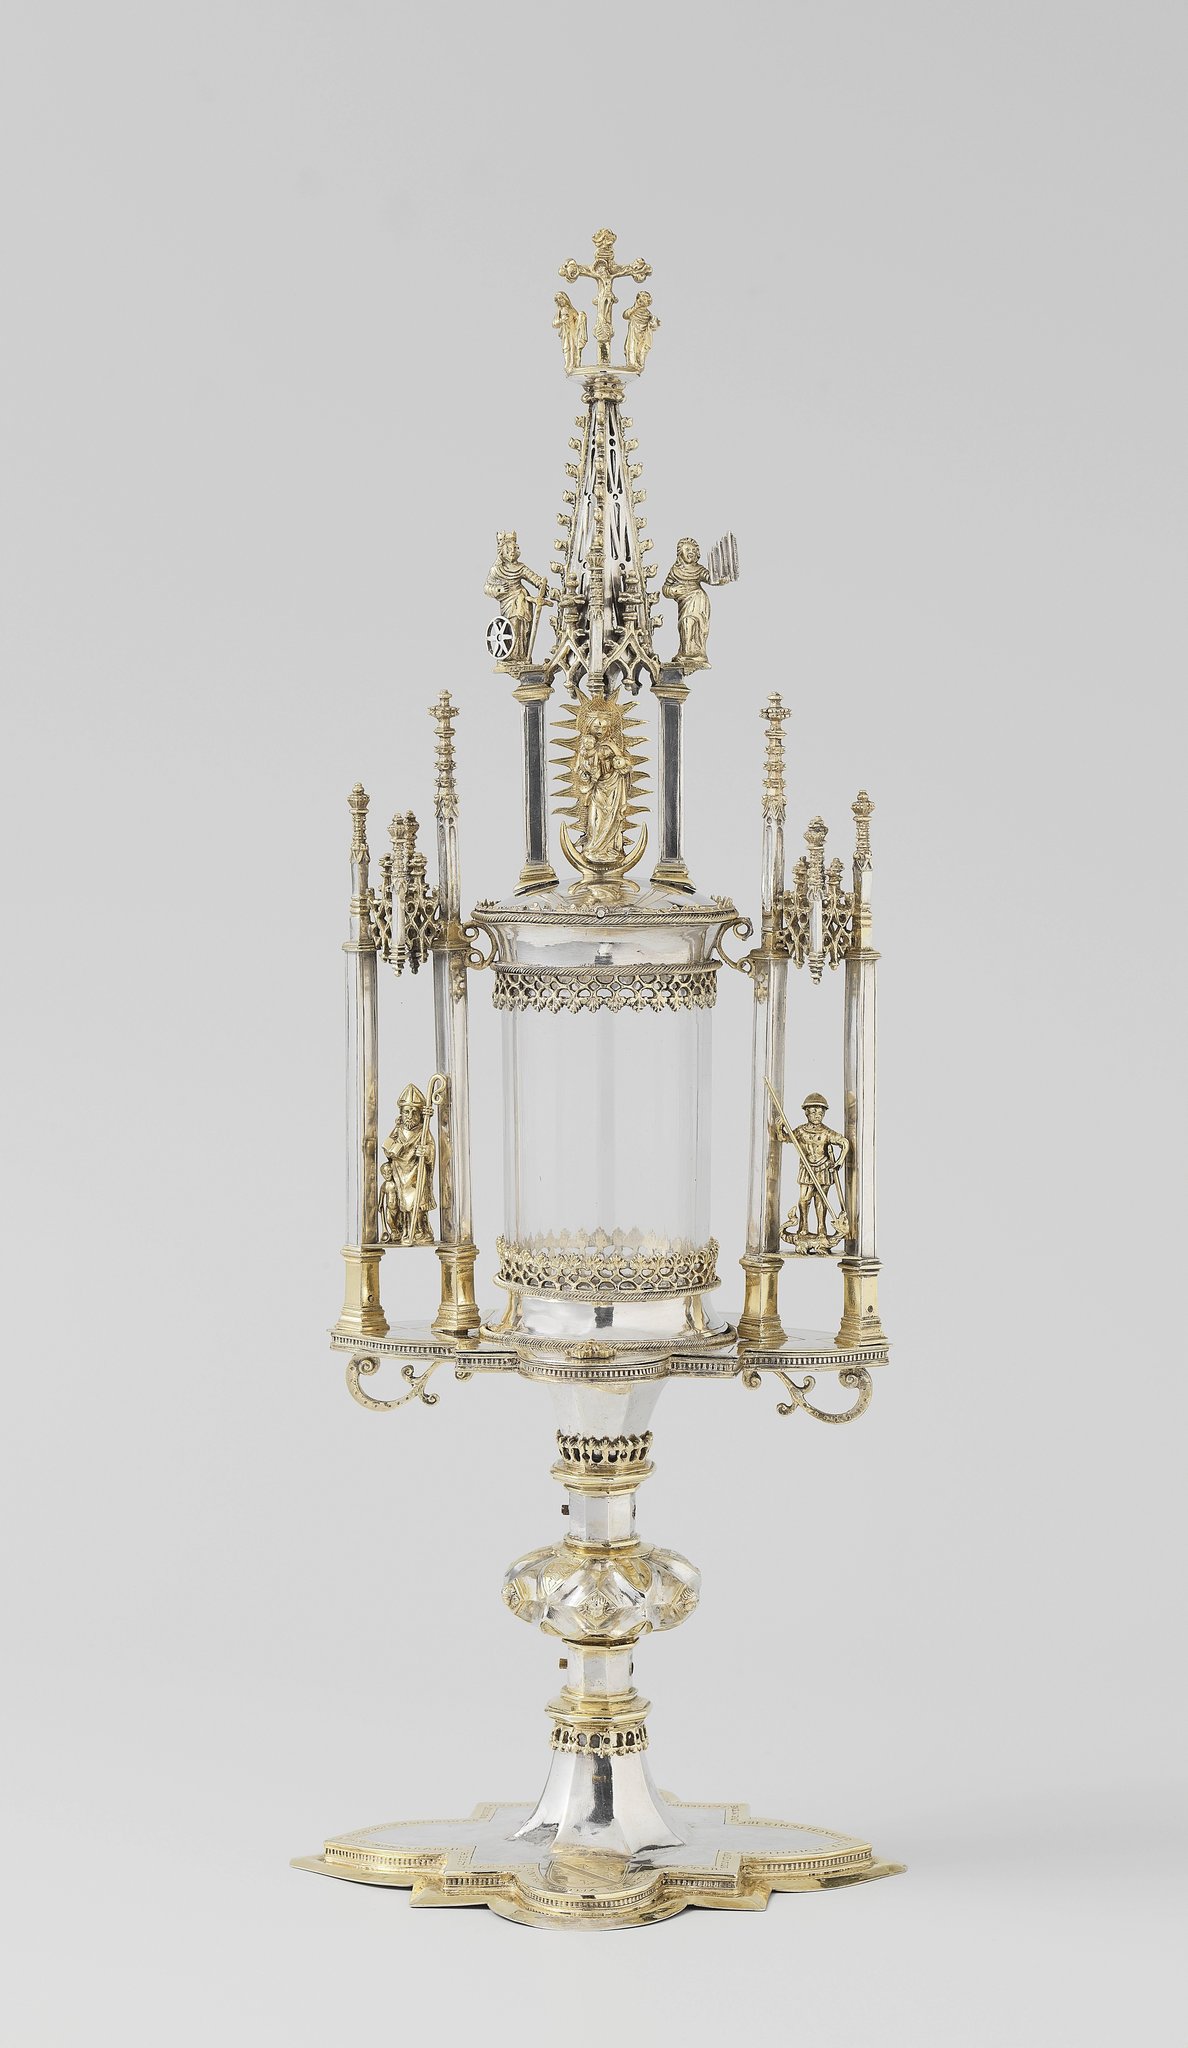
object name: monstrans, ostensorium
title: Monstrans uit een klooster te Sinnich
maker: Anonymous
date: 1525-1550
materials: glass, silver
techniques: gilding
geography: maastricht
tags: the virgin martyr cecilia of rome; possible attributes: falcon, musical instruments, organ, wreath of roses and lilies, the virgin martyr catherine of alexandria; possible attributes: book, crown, emperor maxentius, palm-branch, ring, sword, wheel, augustine, bishop of hippo; possible attributes: arrows piercing his breast, book, child with spoon, flaming heart, heart (pierced with arrows), pen, madonna on the crescent of the moon (sometimes called queen of heaven) (in mandorla), the warrior martyr george (georgius); possible attributes: banner (red cross on white field), (red) cross, dragon, (white) horse, broken lance, shield (with cross), sword, crucified christ with mary and john on either side of the cross; holy rood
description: Monstrance, given by Cecilia Einatten to the monastery at Sinnich. Silver, partially gilded, Maastricht, c. 1525 - 1550, maker's mark: a ship.